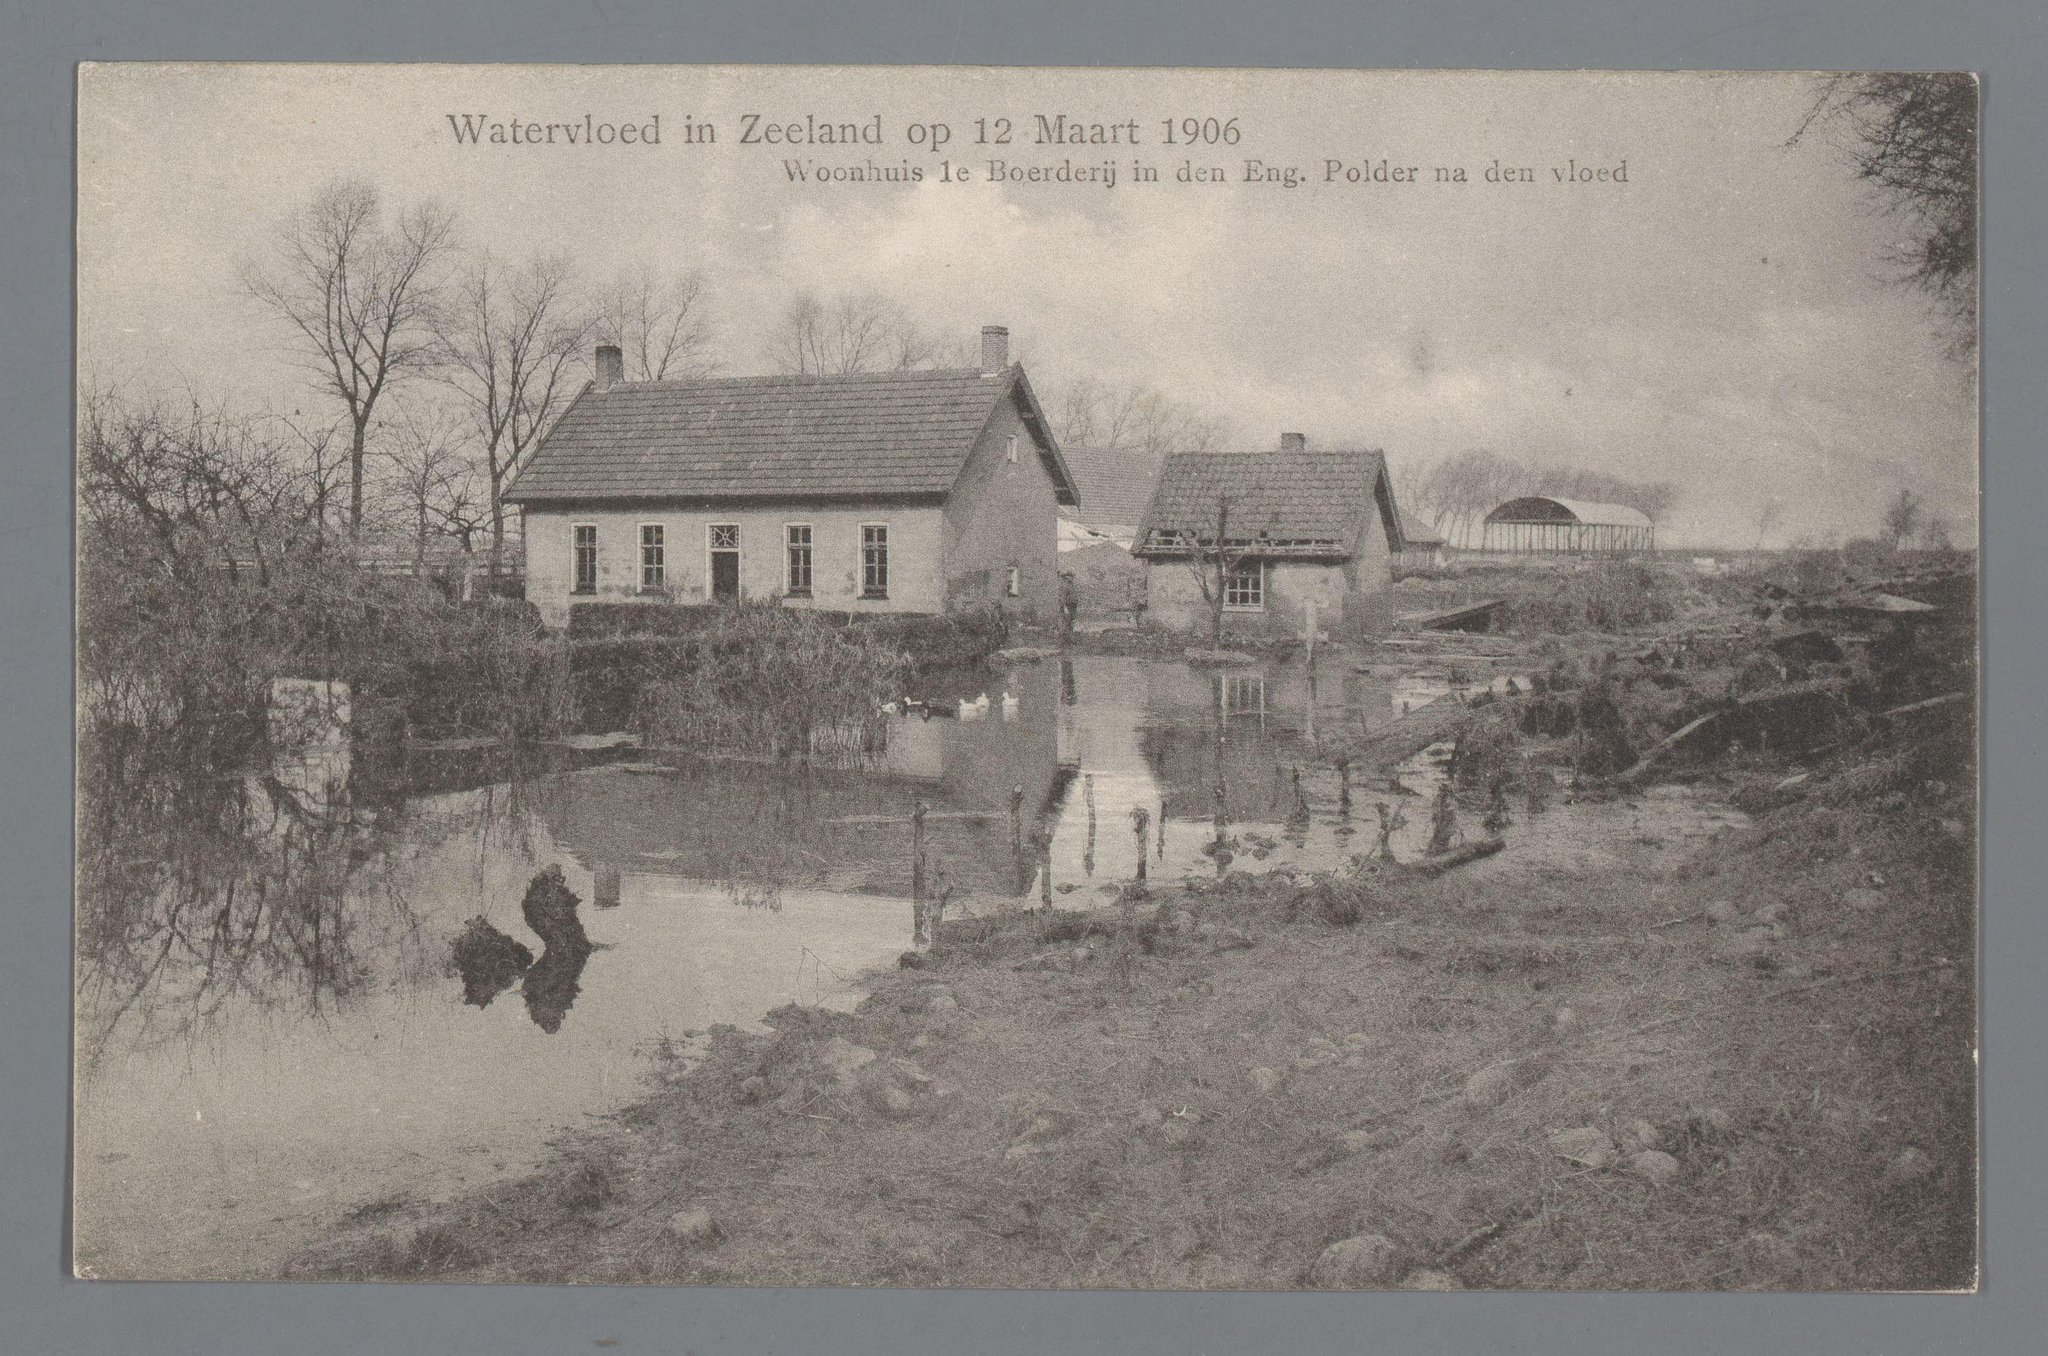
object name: ansichtkaart, prentbriefkaart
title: Watervloed in Zeeland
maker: p.j. daniëlse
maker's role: publisher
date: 1906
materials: paper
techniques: printing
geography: middelburg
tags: zeeland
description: Briefkaart, zwart-wit. Watersnood 12 maart 1906, Zeeland.